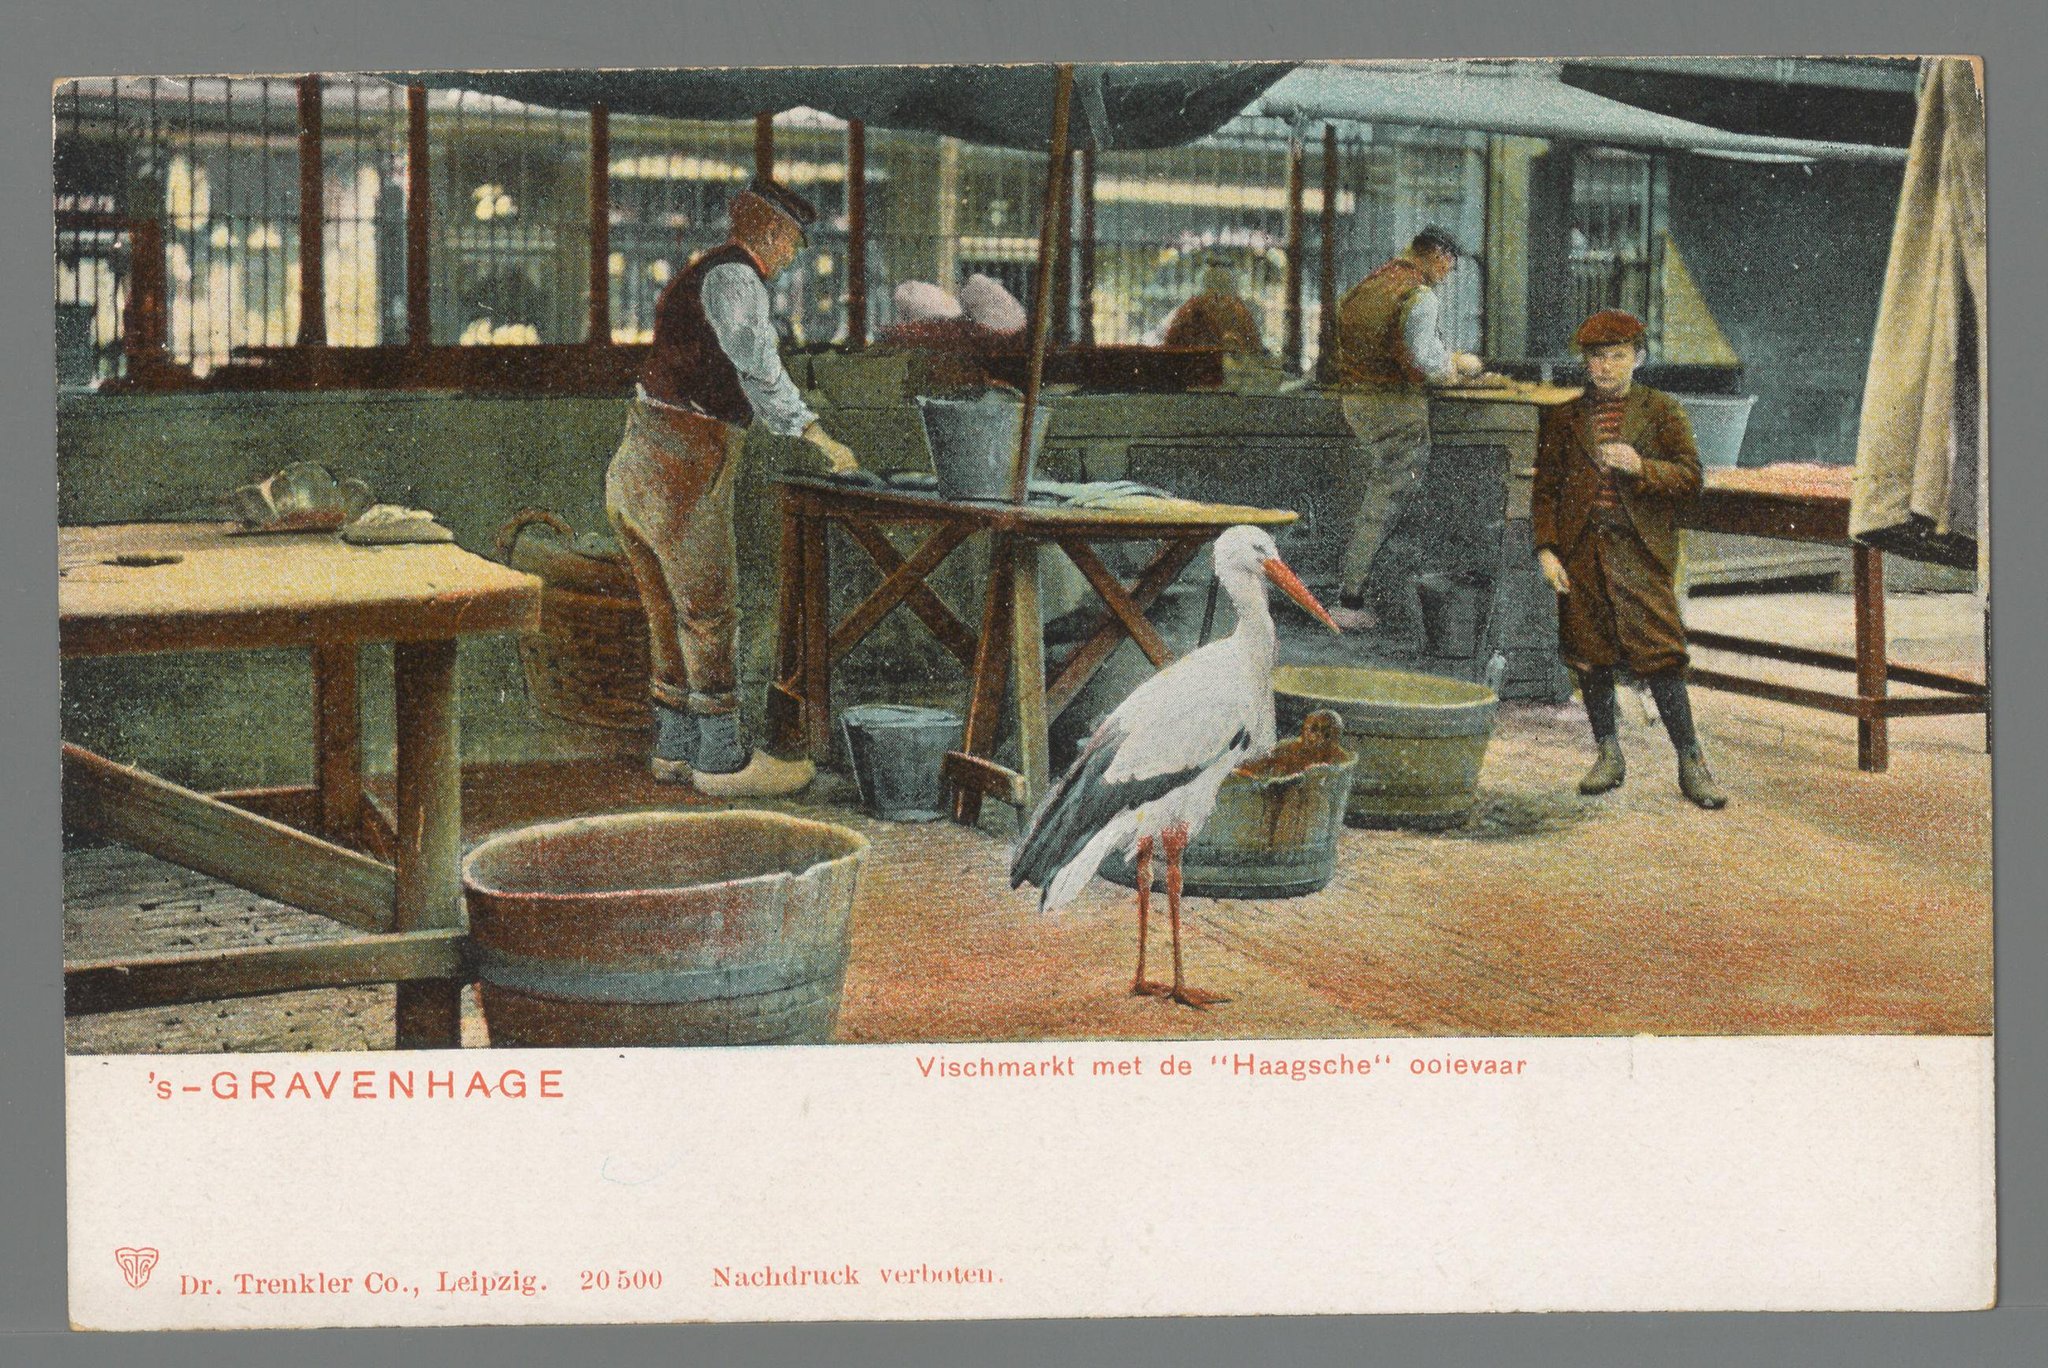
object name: ansichtkaart, prentbriefkaart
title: 's-Gravenhage. Vischmarkt met de "Haagsche" ooievaar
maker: Anonymous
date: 1897-1905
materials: cardboard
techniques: lithograph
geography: the hague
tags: wooden container: barrel, cask, bucket, shore-birds and wading-birds: heron, fishes, stall, booth (~ market), the hague